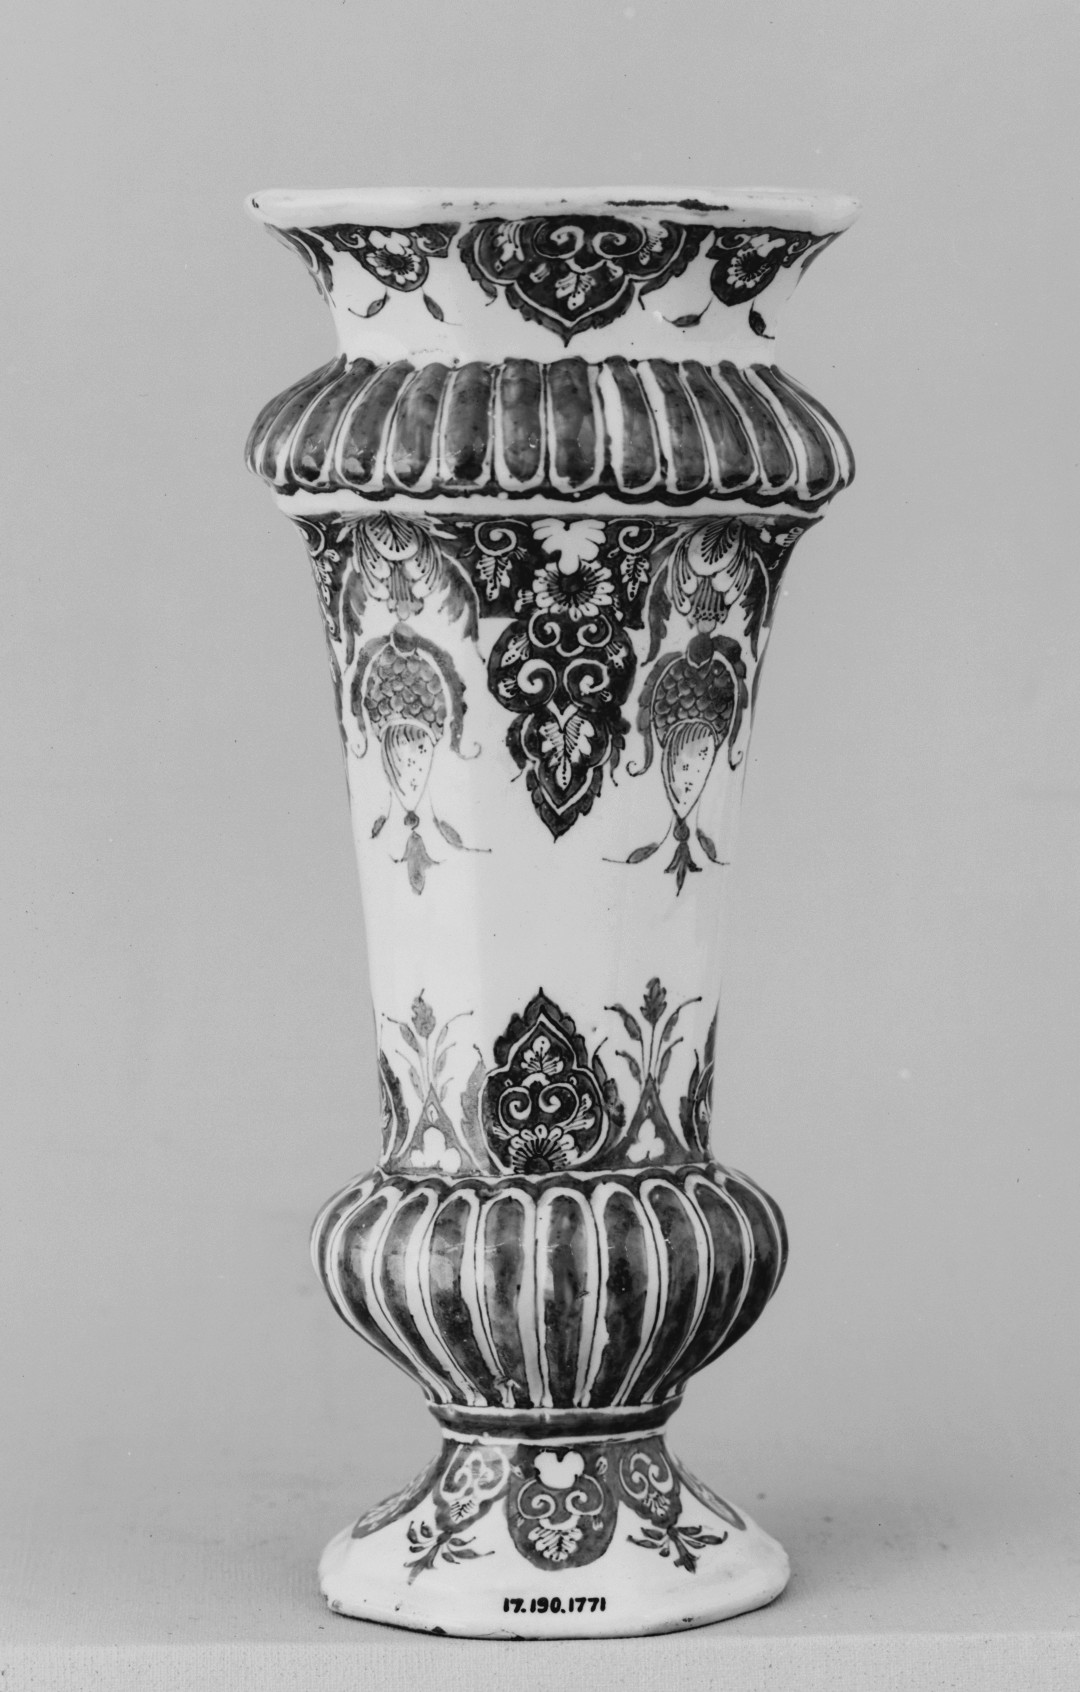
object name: vase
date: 1705-1720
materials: faience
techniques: glazing